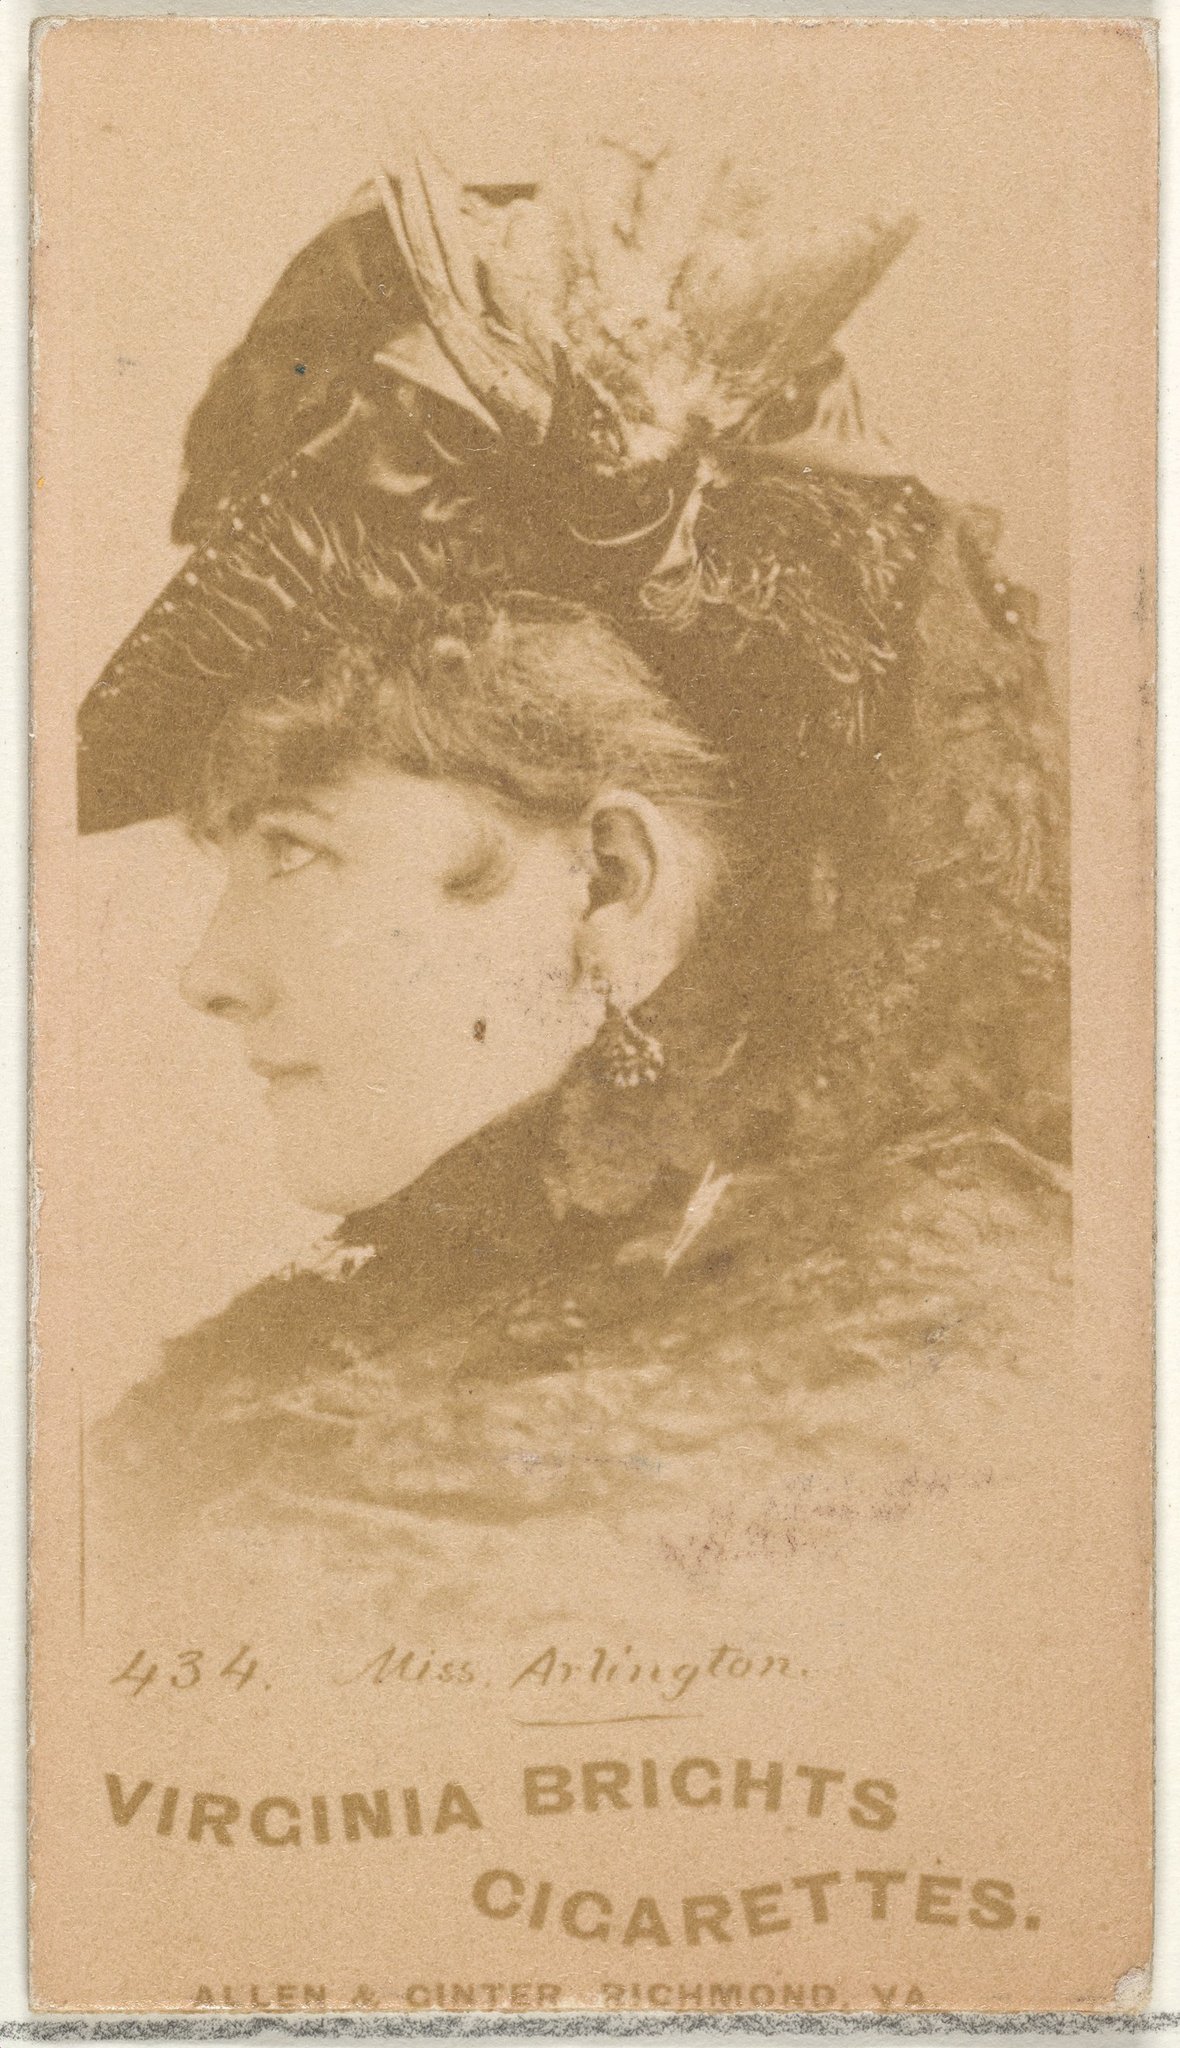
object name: photograph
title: Card 434, Miss Arlington, from the Actors and Actresses series (N45, Type 1) for Virginia Brights Cigarettes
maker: allen & ginter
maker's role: publisher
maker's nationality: american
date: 1888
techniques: albumen silver print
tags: portraits,profiles,women,actresses